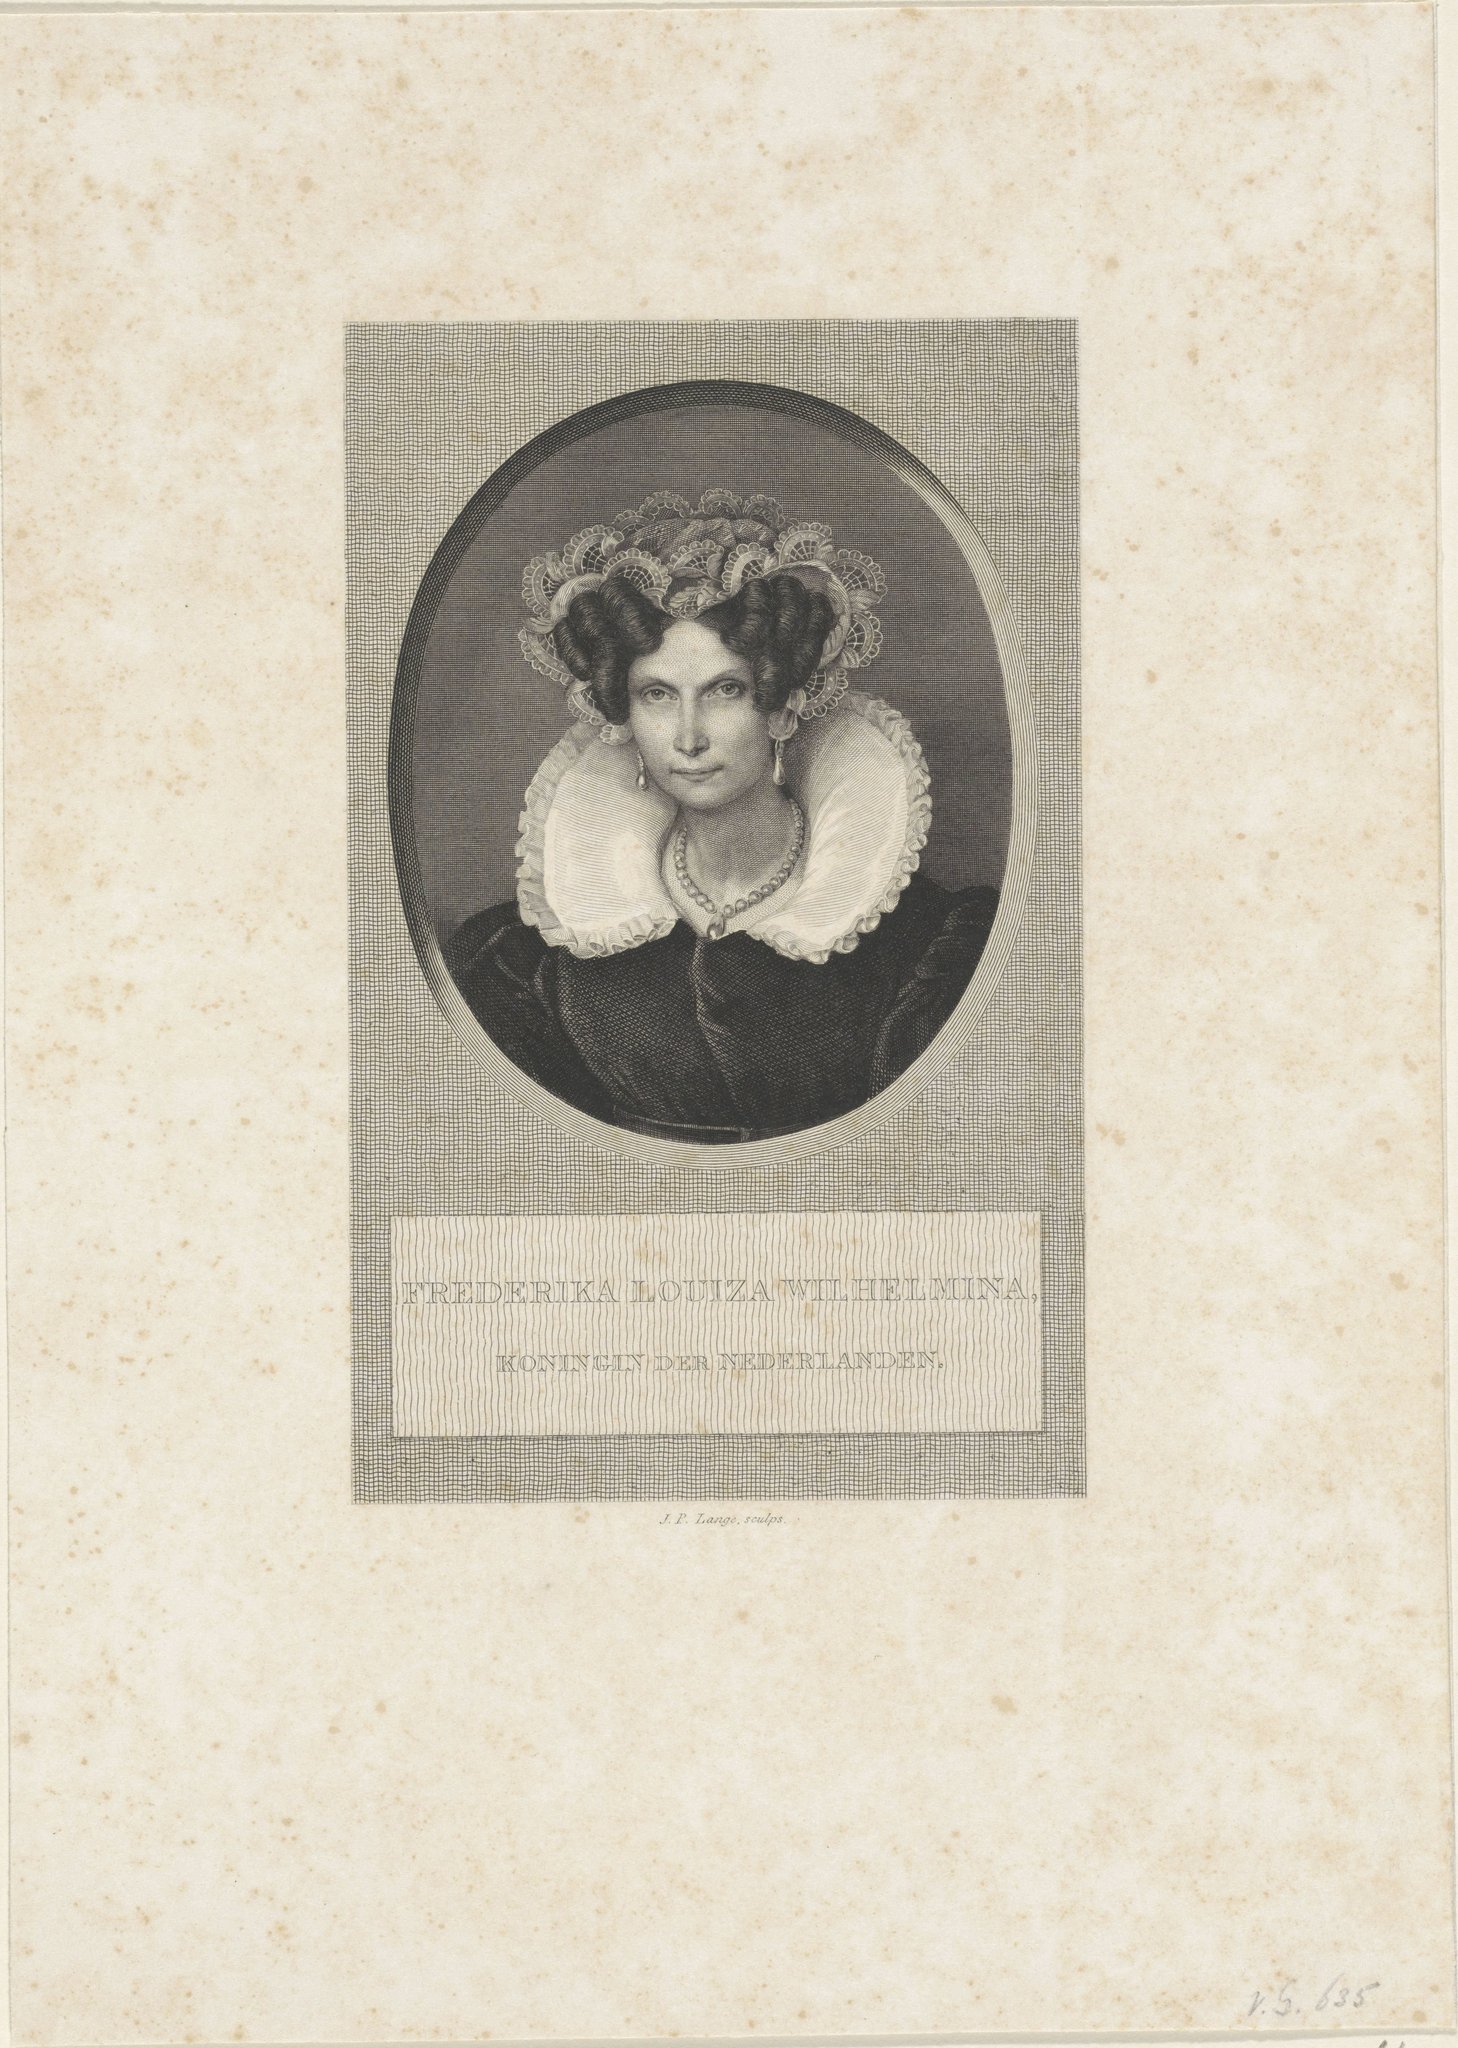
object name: print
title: Portret van Wilhelmina van Pruisen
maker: johannes philippus lange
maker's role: print maker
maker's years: 1810-1849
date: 1825-1849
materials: paper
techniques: engraving, etching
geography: amsterdam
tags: berlin, the hague, wilhelmina frederica louisa (koningin der nederlanden)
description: Portret van Wilhelmina in een ovaal. In de ondermarge haar naam en titel.